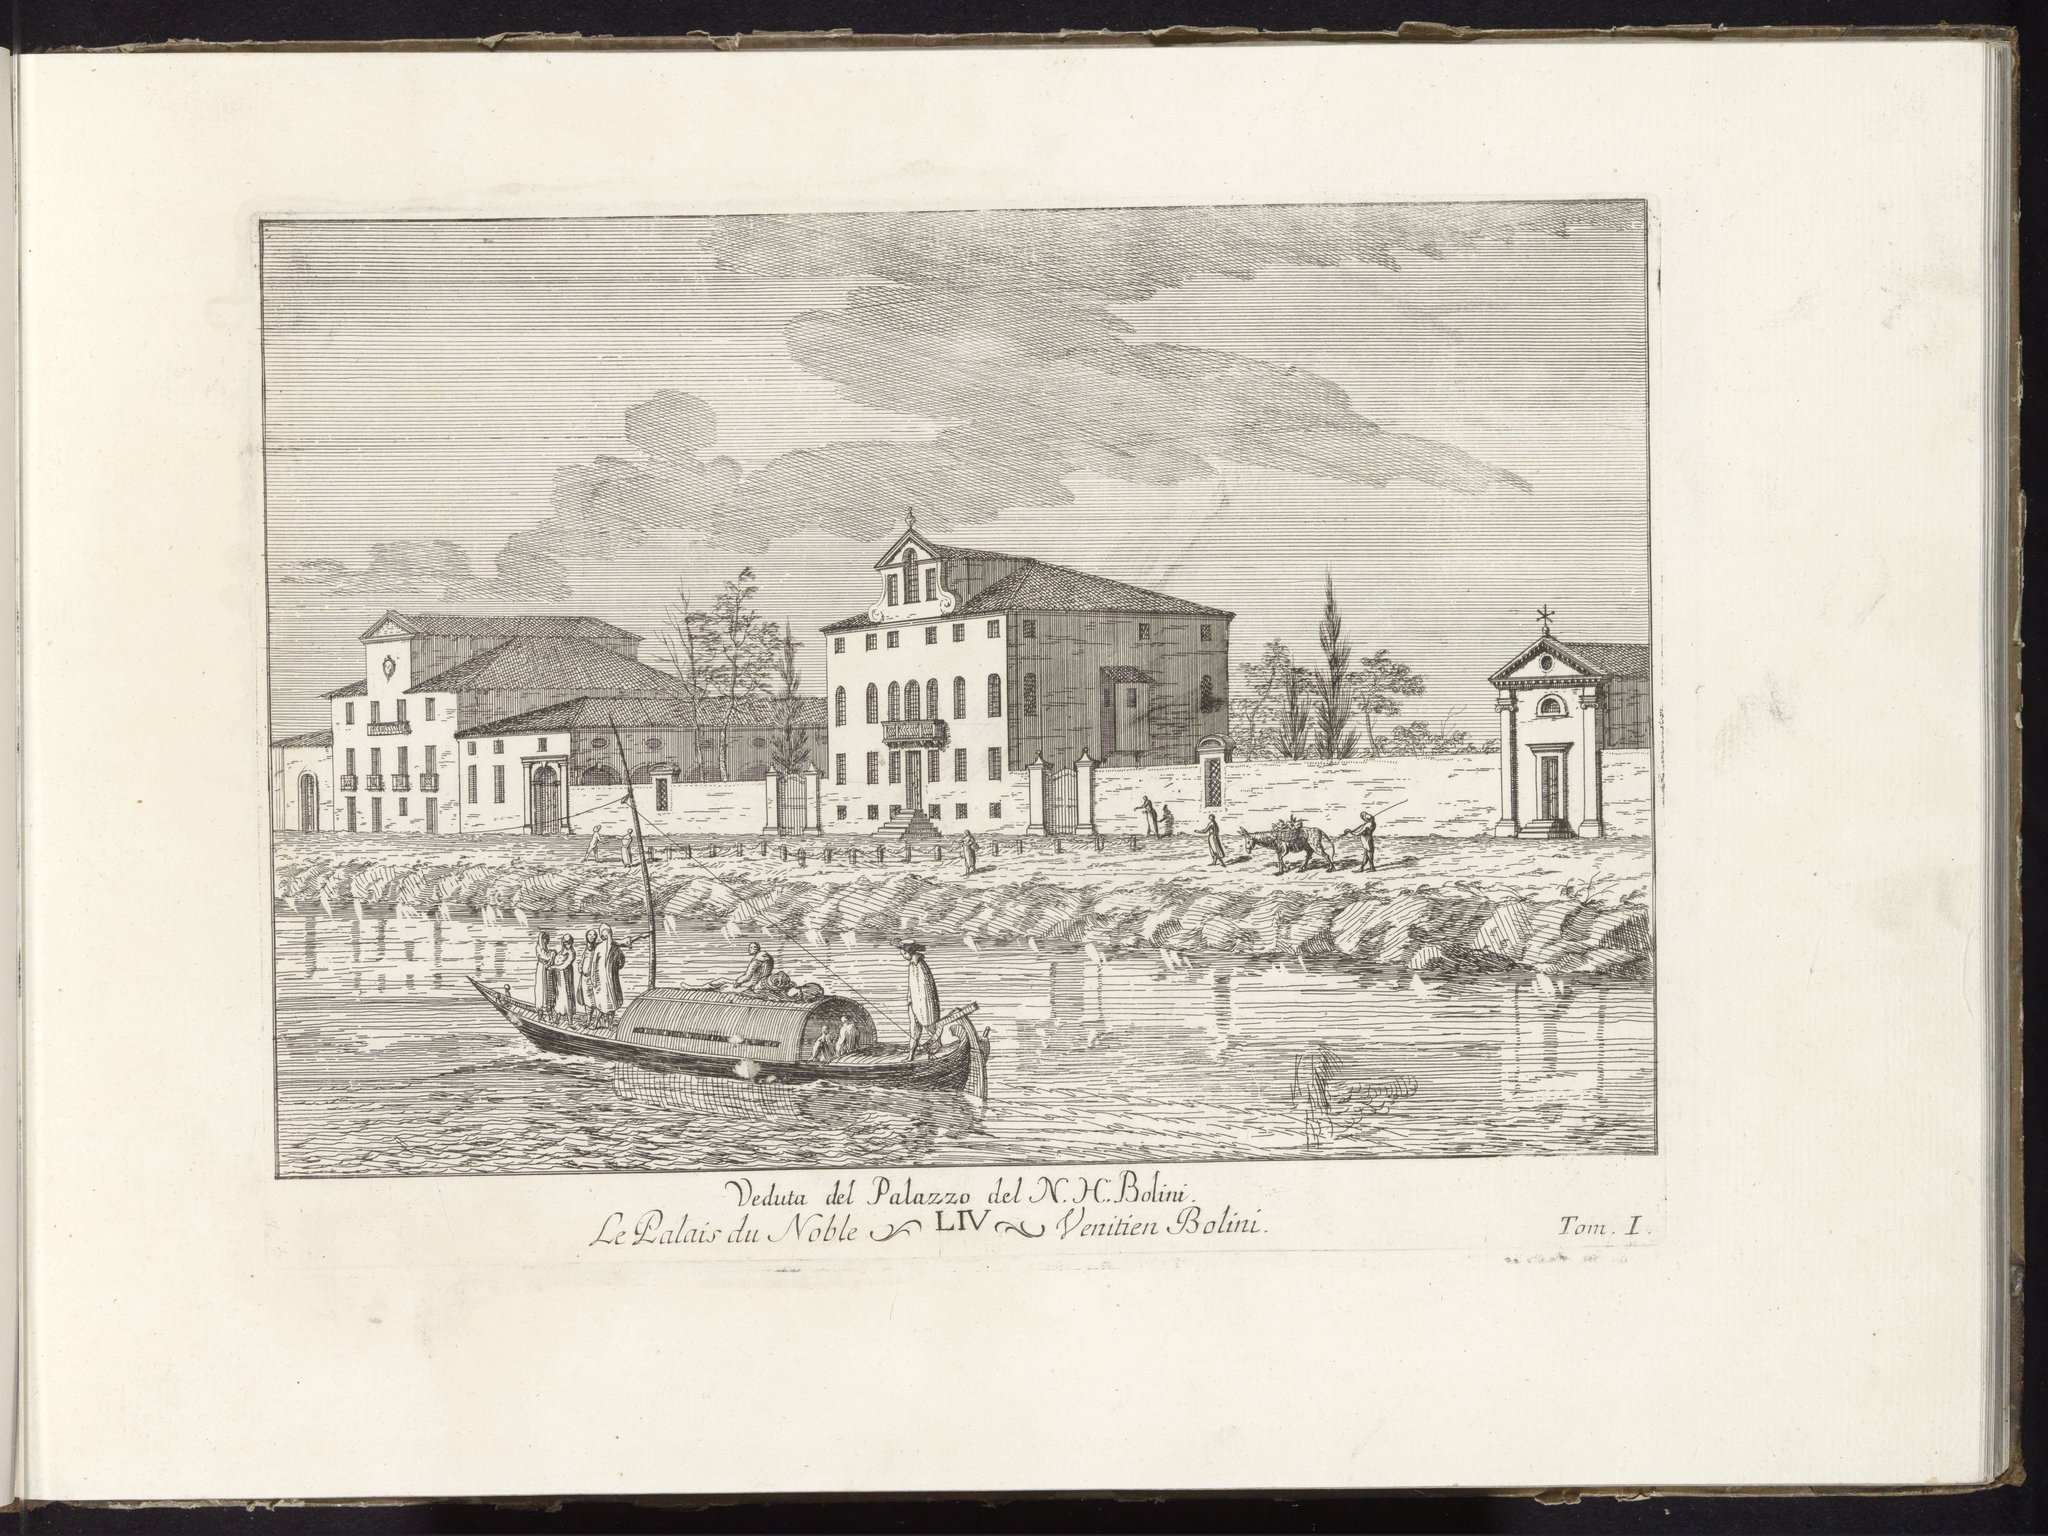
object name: print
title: Gezichten op de rivier de Brenta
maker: giovanni francesco costa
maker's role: draughtsman, painter, print maker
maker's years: -1773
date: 1750-1760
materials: paper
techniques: etching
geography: venice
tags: river, tow-boat, towing-barge, hôtel, i.e. small palace in city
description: Gezicht op Palazzo del N. H. Bolini aan de rivier de Brenta. Op het water vaart een trekschuit. Genummerd midden onder: LIV en rechtsonder: Tom: I. Deze prent maakt deel uit van een album.